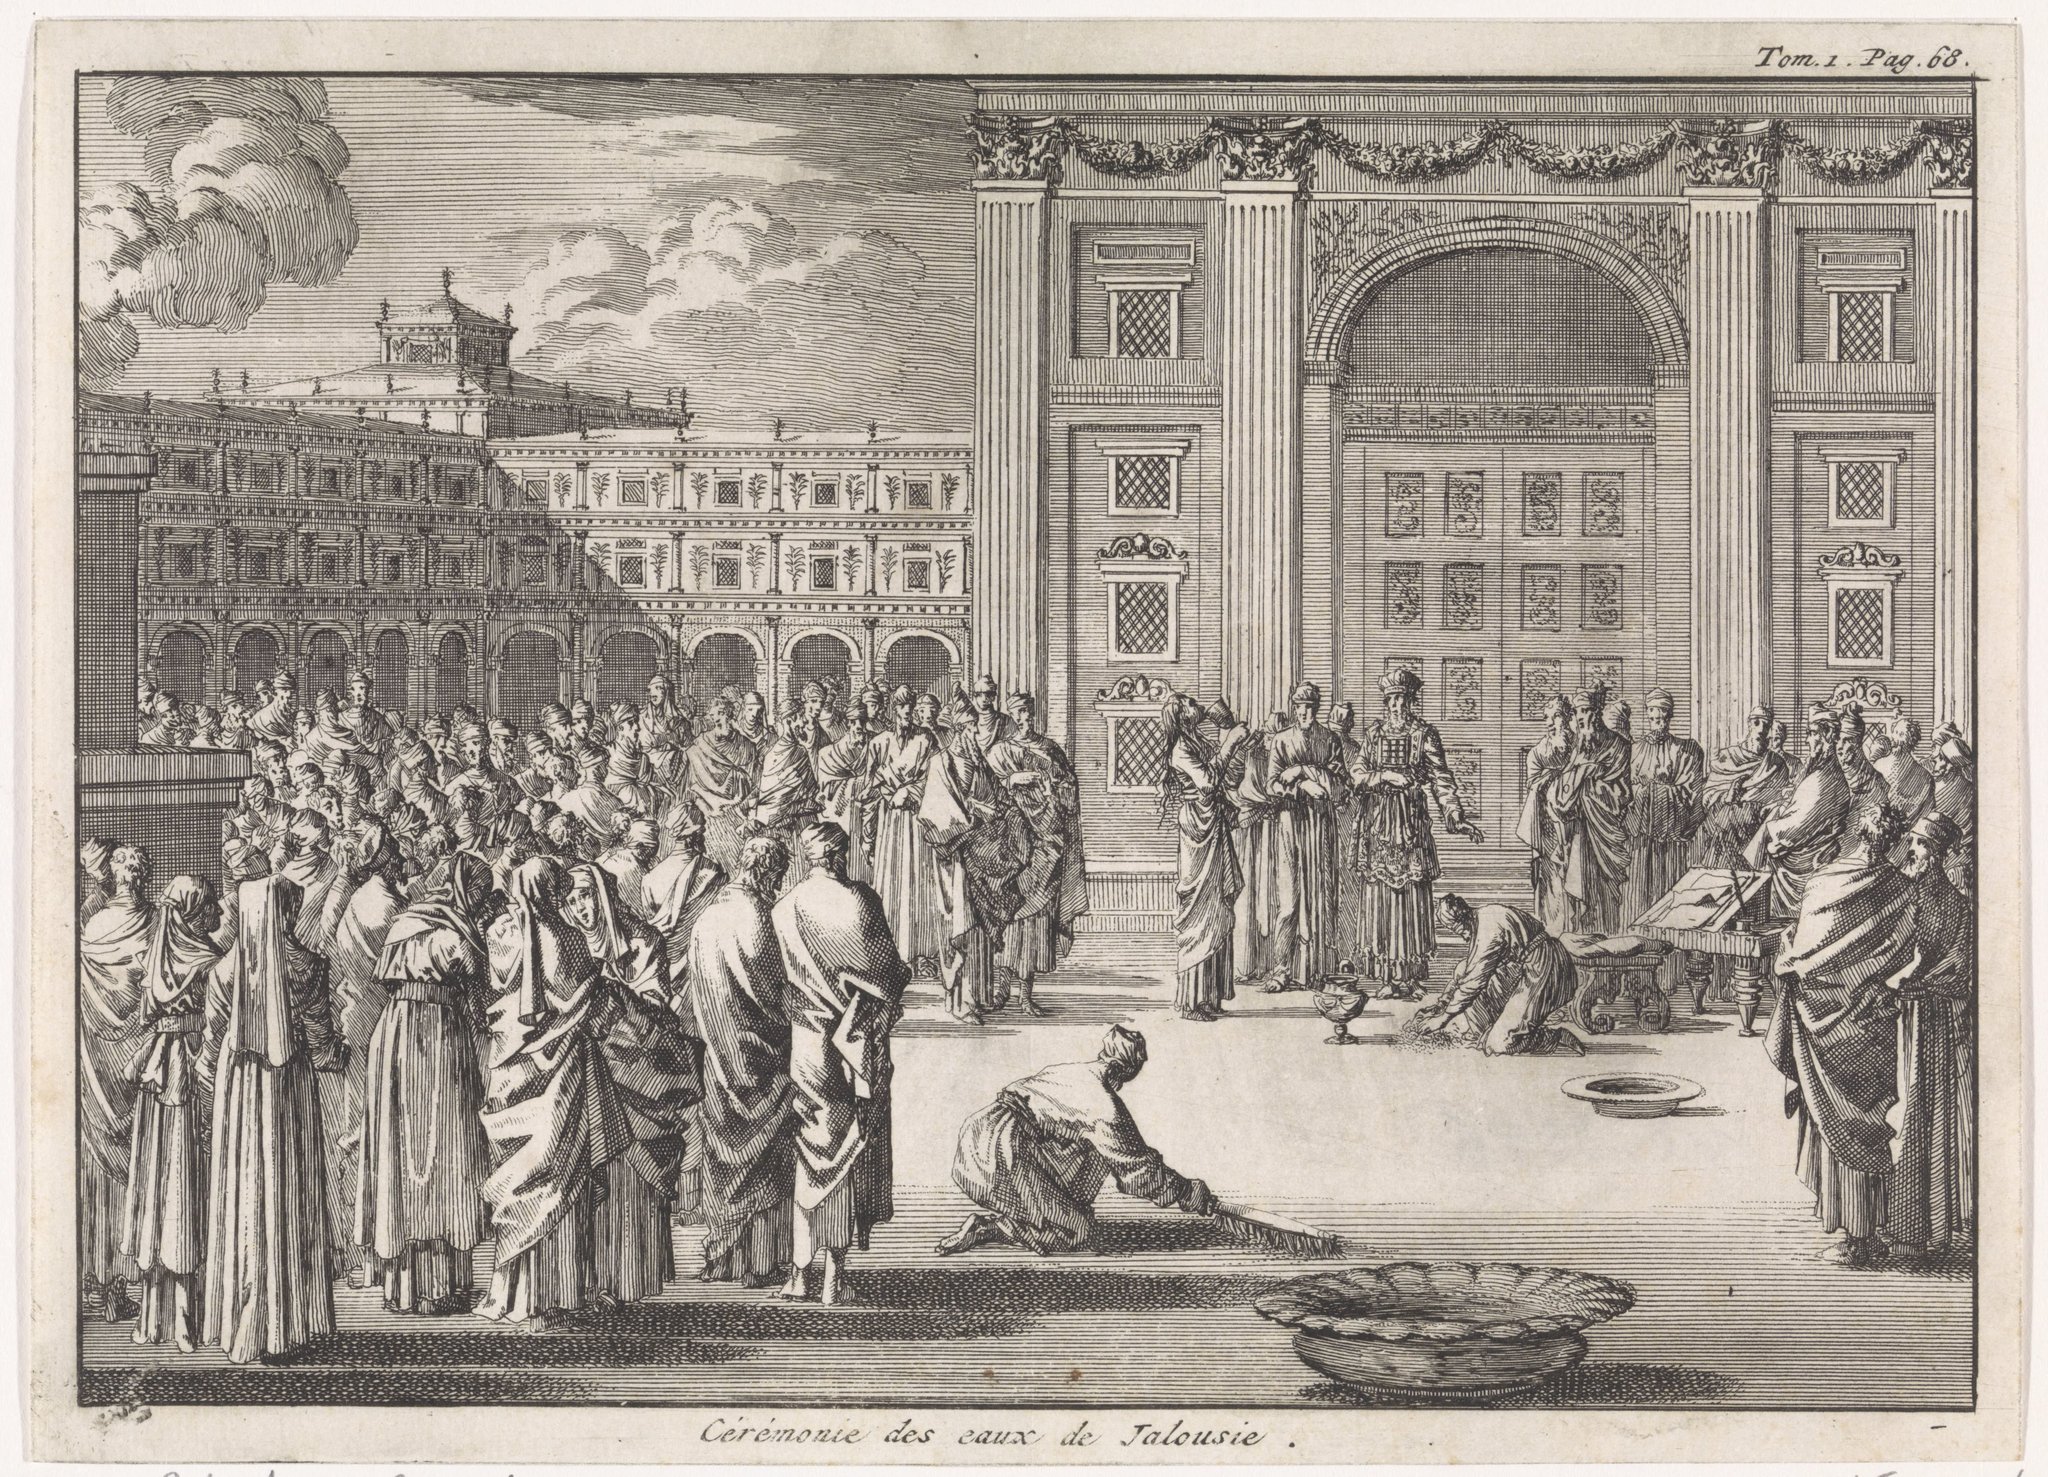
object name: book illustration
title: Ceremonie met van overspel verdachte vrouwen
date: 1705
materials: paper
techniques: etching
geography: amsterdam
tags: adulterer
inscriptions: collector's mark: Lugt 2228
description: Illustratie uit: Cunaeus, Petrus. La republique des Hebreux, 3 delen. Amsterdam: Pieter Mortier, 1705, dl. I, p. 68.